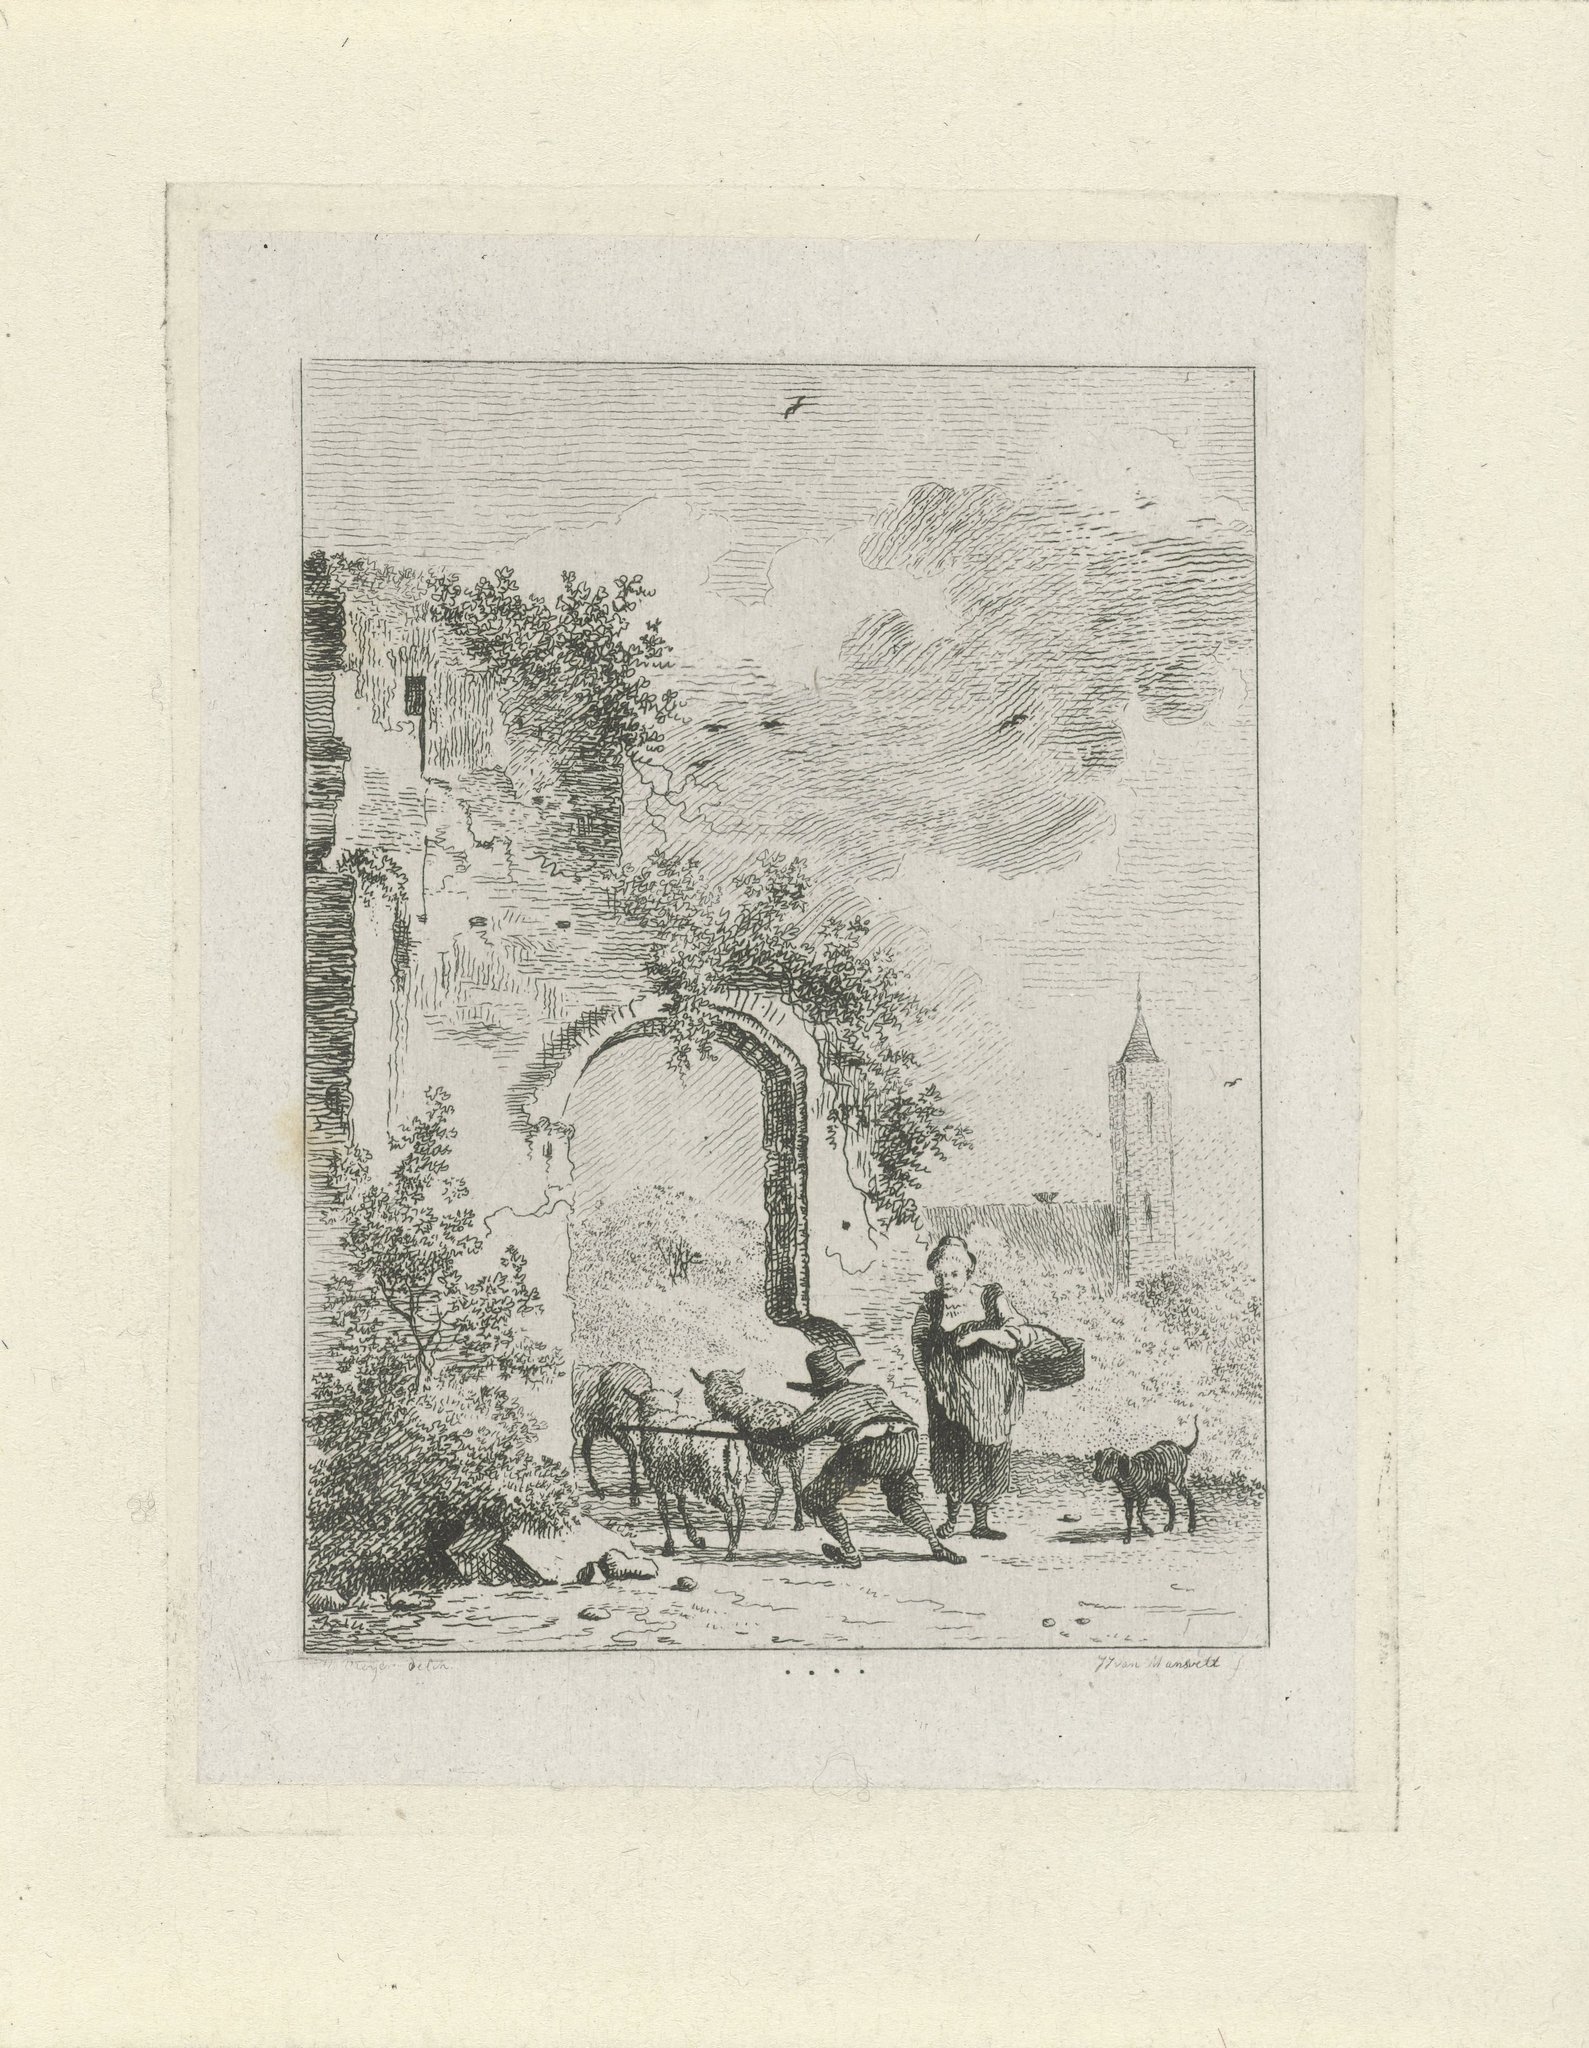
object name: print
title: Herder met schapen bij een poort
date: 1771-1802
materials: paper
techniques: etching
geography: netherlands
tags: herding, herdsman, herdswoman, shepherd, shepherdess, cowherd, etc., landscapes in the temperate zone, gate, entrance, cattle driving, cattle driver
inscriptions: collector's mark: Lugt 2227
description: Een herder drijft zijn kudde schapen door een poort, naast hem een vrouw met een mand aan haar arm. Rechts een hond.